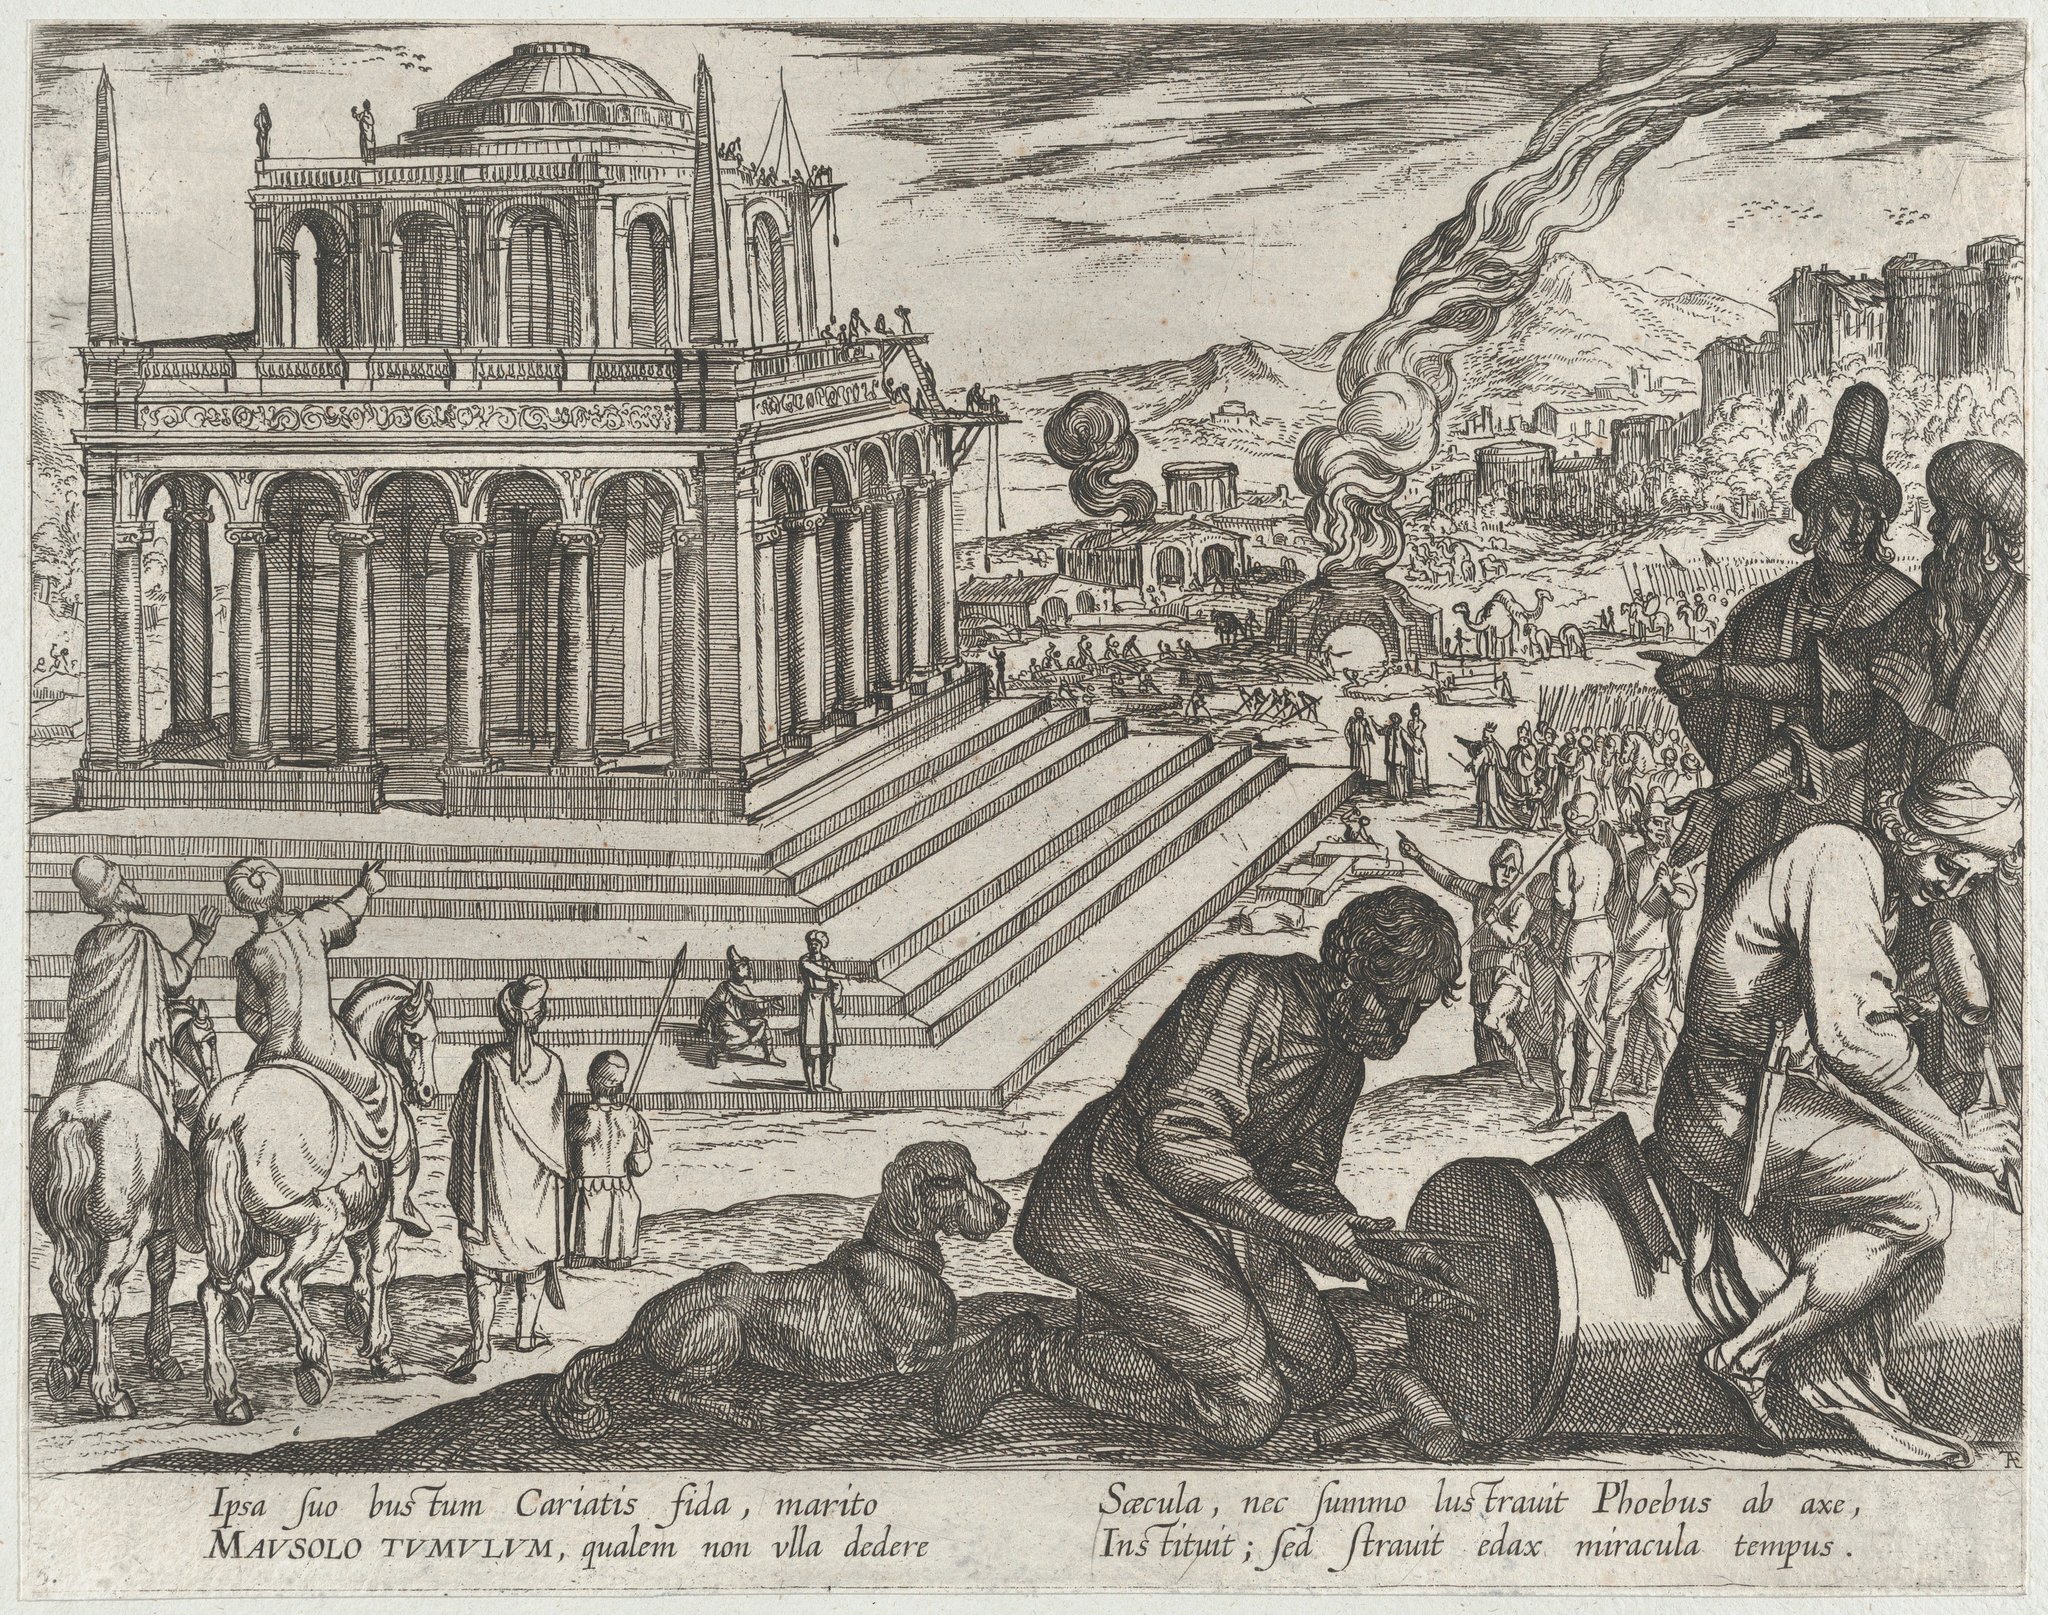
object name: print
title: Plate 5: The Tomb of Mausolus, from "The Seven Wonders of the World"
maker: antonio tempesta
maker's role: artist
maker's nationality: italian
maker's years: 1555-1630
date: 1608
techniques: etching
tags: tombs,men,dogs,horses